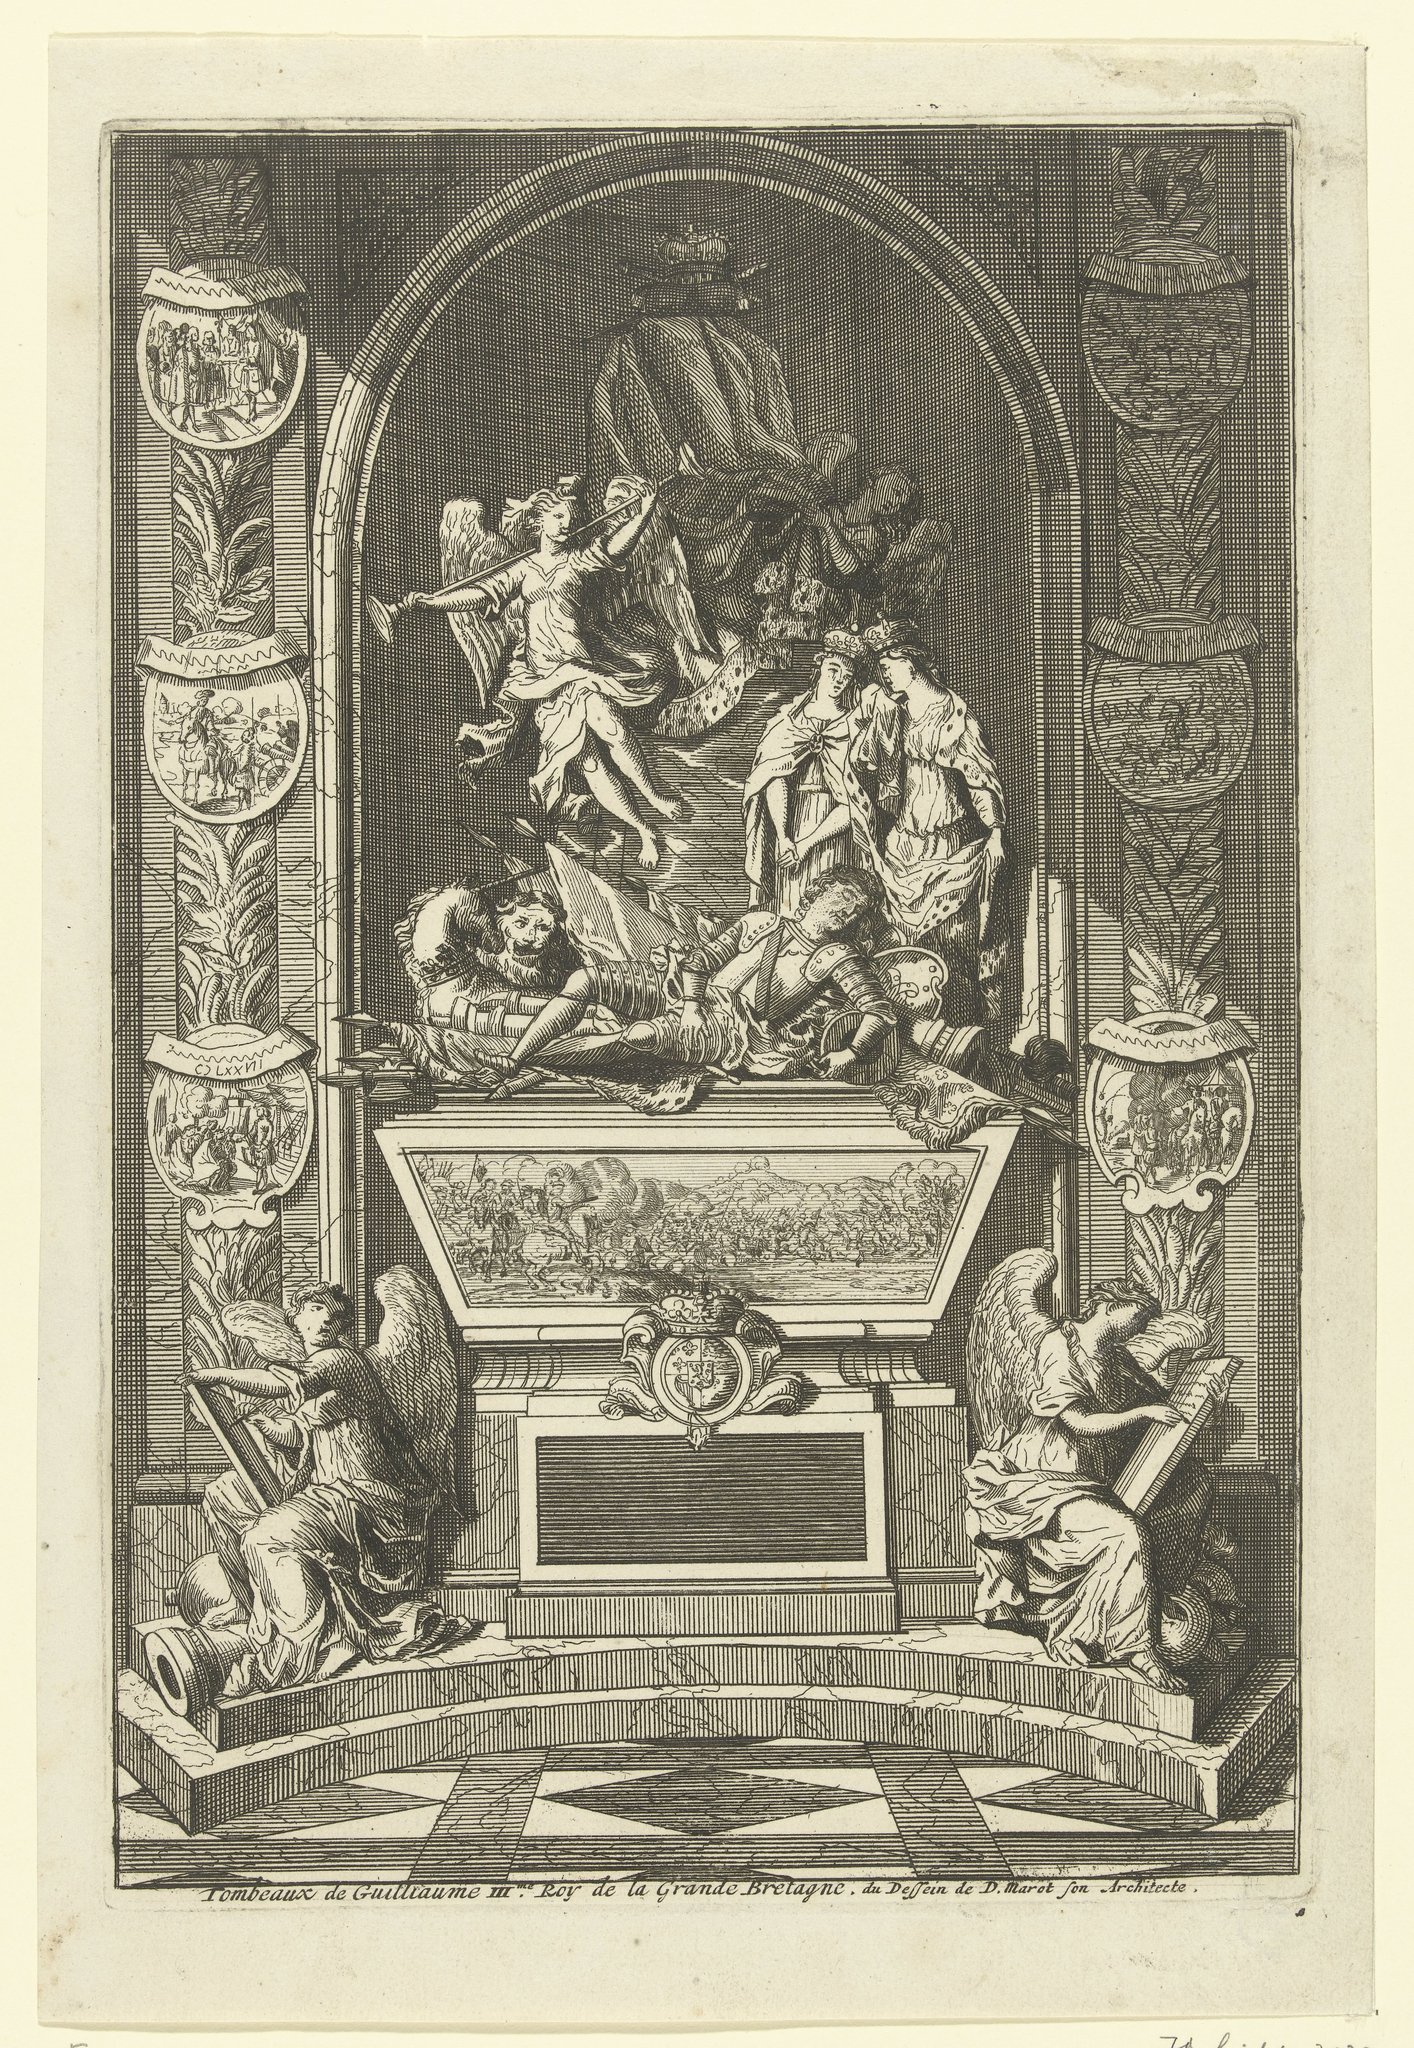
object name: print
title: Tombeaux de Guillaume IIIme. Roy de la Grande Bretagne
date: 1702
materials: paper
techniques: etching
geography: low countries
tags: william iii (prince of orange and king of england, scotland, and ireland), fame; 'fama', 'fama buona', 'fama chiara' (ripa) (+ abstract concept represented by female figure), grave-building, monumental tomb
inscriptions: collector's mark: Lugt 2228, collector's mark: Lugt 963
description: Grafmonument voor Willem III, overleden op 19 maart 1702. Niet uitgevoerd ontwerp met de Willem III liggend in wapenrusting op zijn kist, huilende Britse en Nederlandse Maagden, en de Faam. Op de voorgrond twee schrijvende engelen.